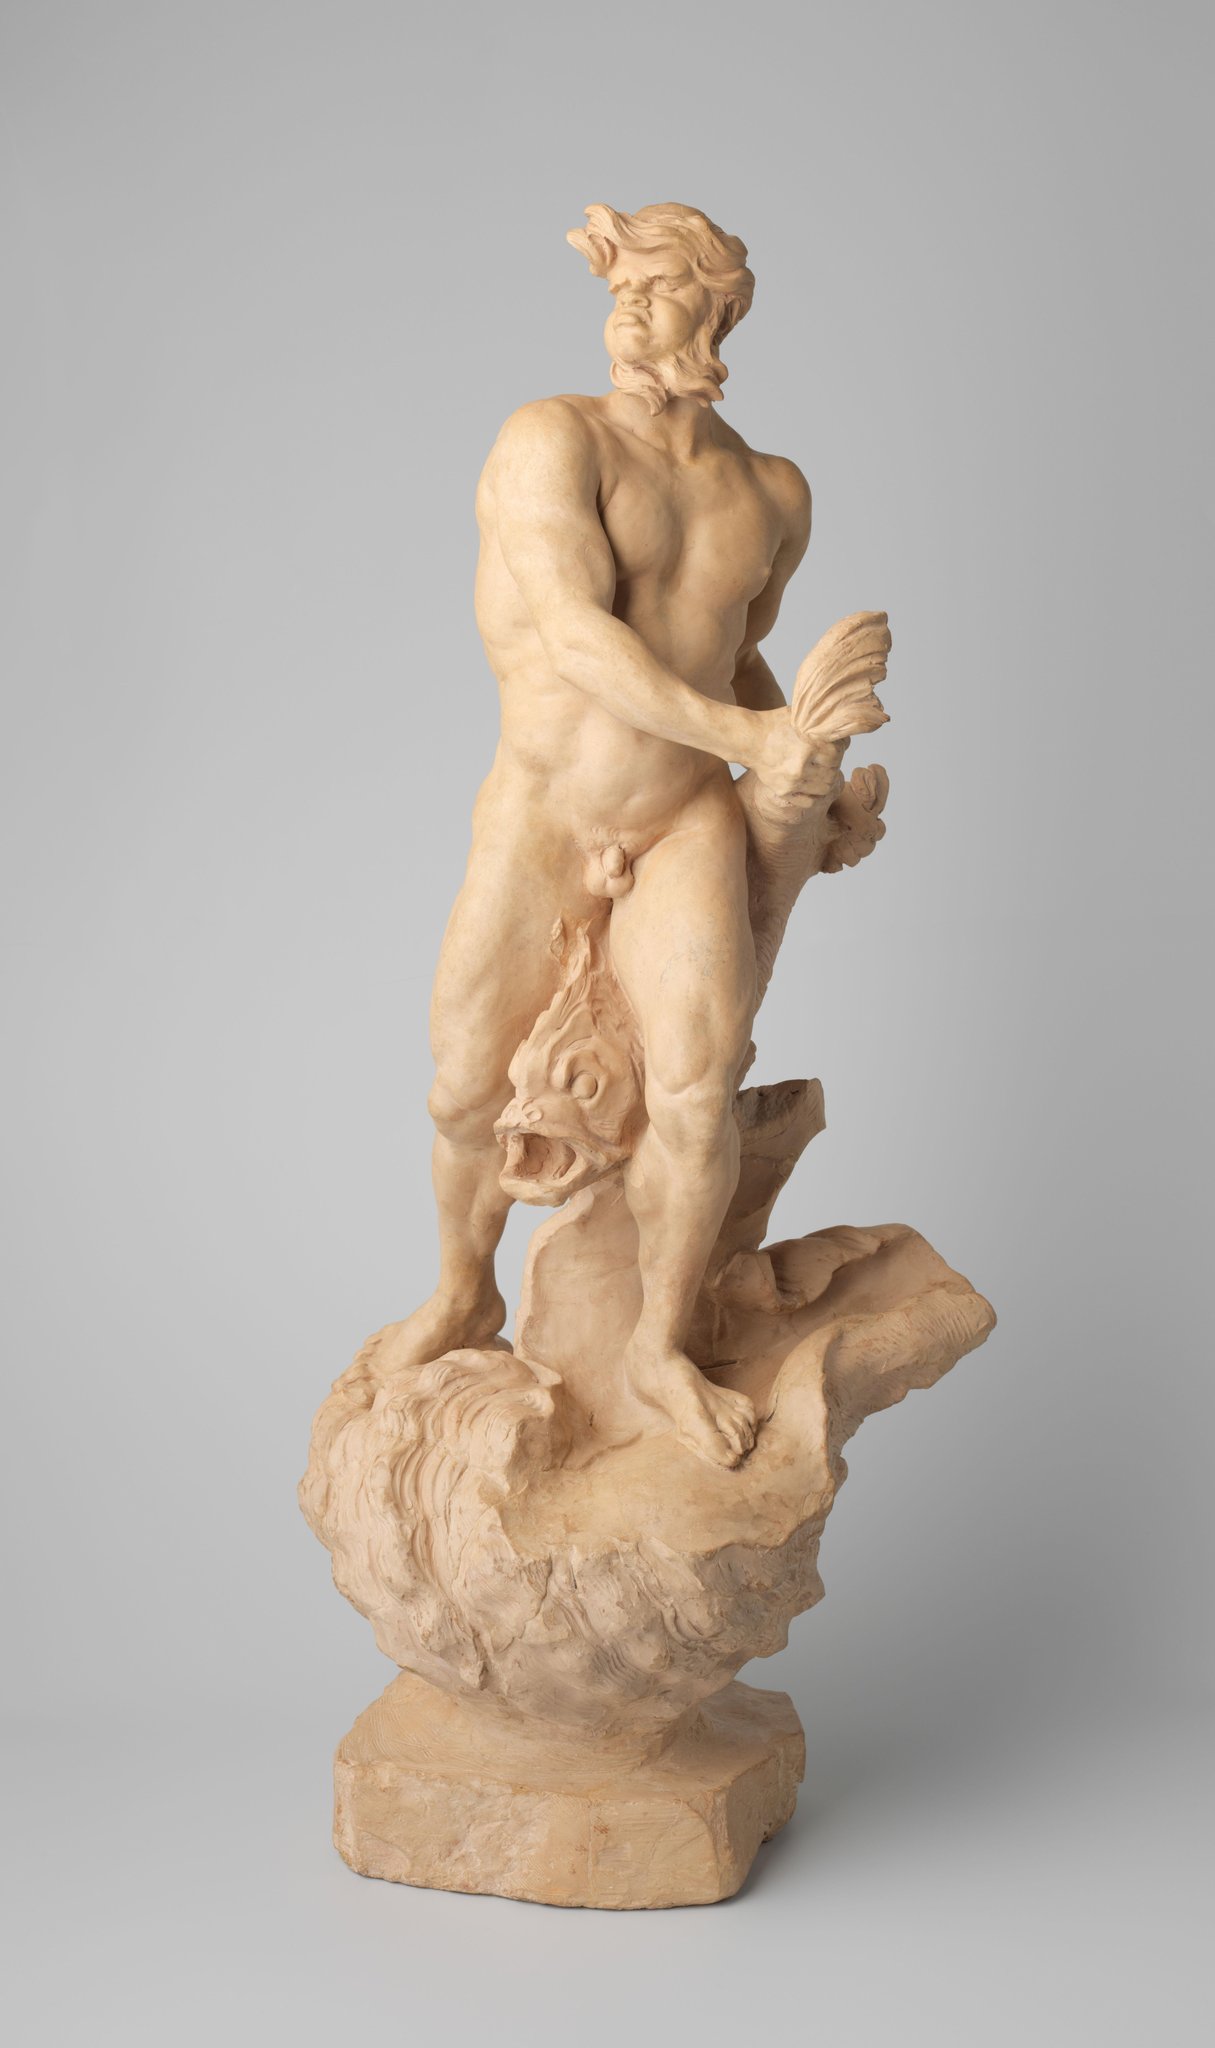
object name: sculpture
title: Triton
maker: giovanni lorenzo bernini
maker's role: draughtsman, painter, sculptor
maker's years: 1598-1680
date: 1653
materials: terracotta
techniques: molding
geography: rome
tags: triton(s), ornamental fountain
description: Een Triton met expressieve gezichtsuitdrukking, die een vis met opengesperde bek vastklemt met zijn handen en tussen zijn benen, terwijl hij staat op een ‘drijvende’ kinkhoorn. Het betreft het eigenhandige model van Bernini voor de centrale figuur in zijn Fontana del Moro op Piazza Navona in Rome. Het beeld heeft een zeer dynamische uitstraling door de torsie in het gespierde lichaam en zijn voorwaarts stappende beweging. Varend op zijn enorme schelp – in de denkbeeldige richting van de grote Fontana dei quattro fiumi midden op de piazza – wordt hij voortgestuwd door een imaginaire wind die de lokken en de baard van het zeewezen vanachteren doet opwaaien. De grote tegenspartelende vis (‘dolfijn’) in de greep van de Triton suggereert een enorme krachtsinspanning, die in de uitgevoerde fontein nog wordt versterkt door het water dat uit de bek van het dier spuit.